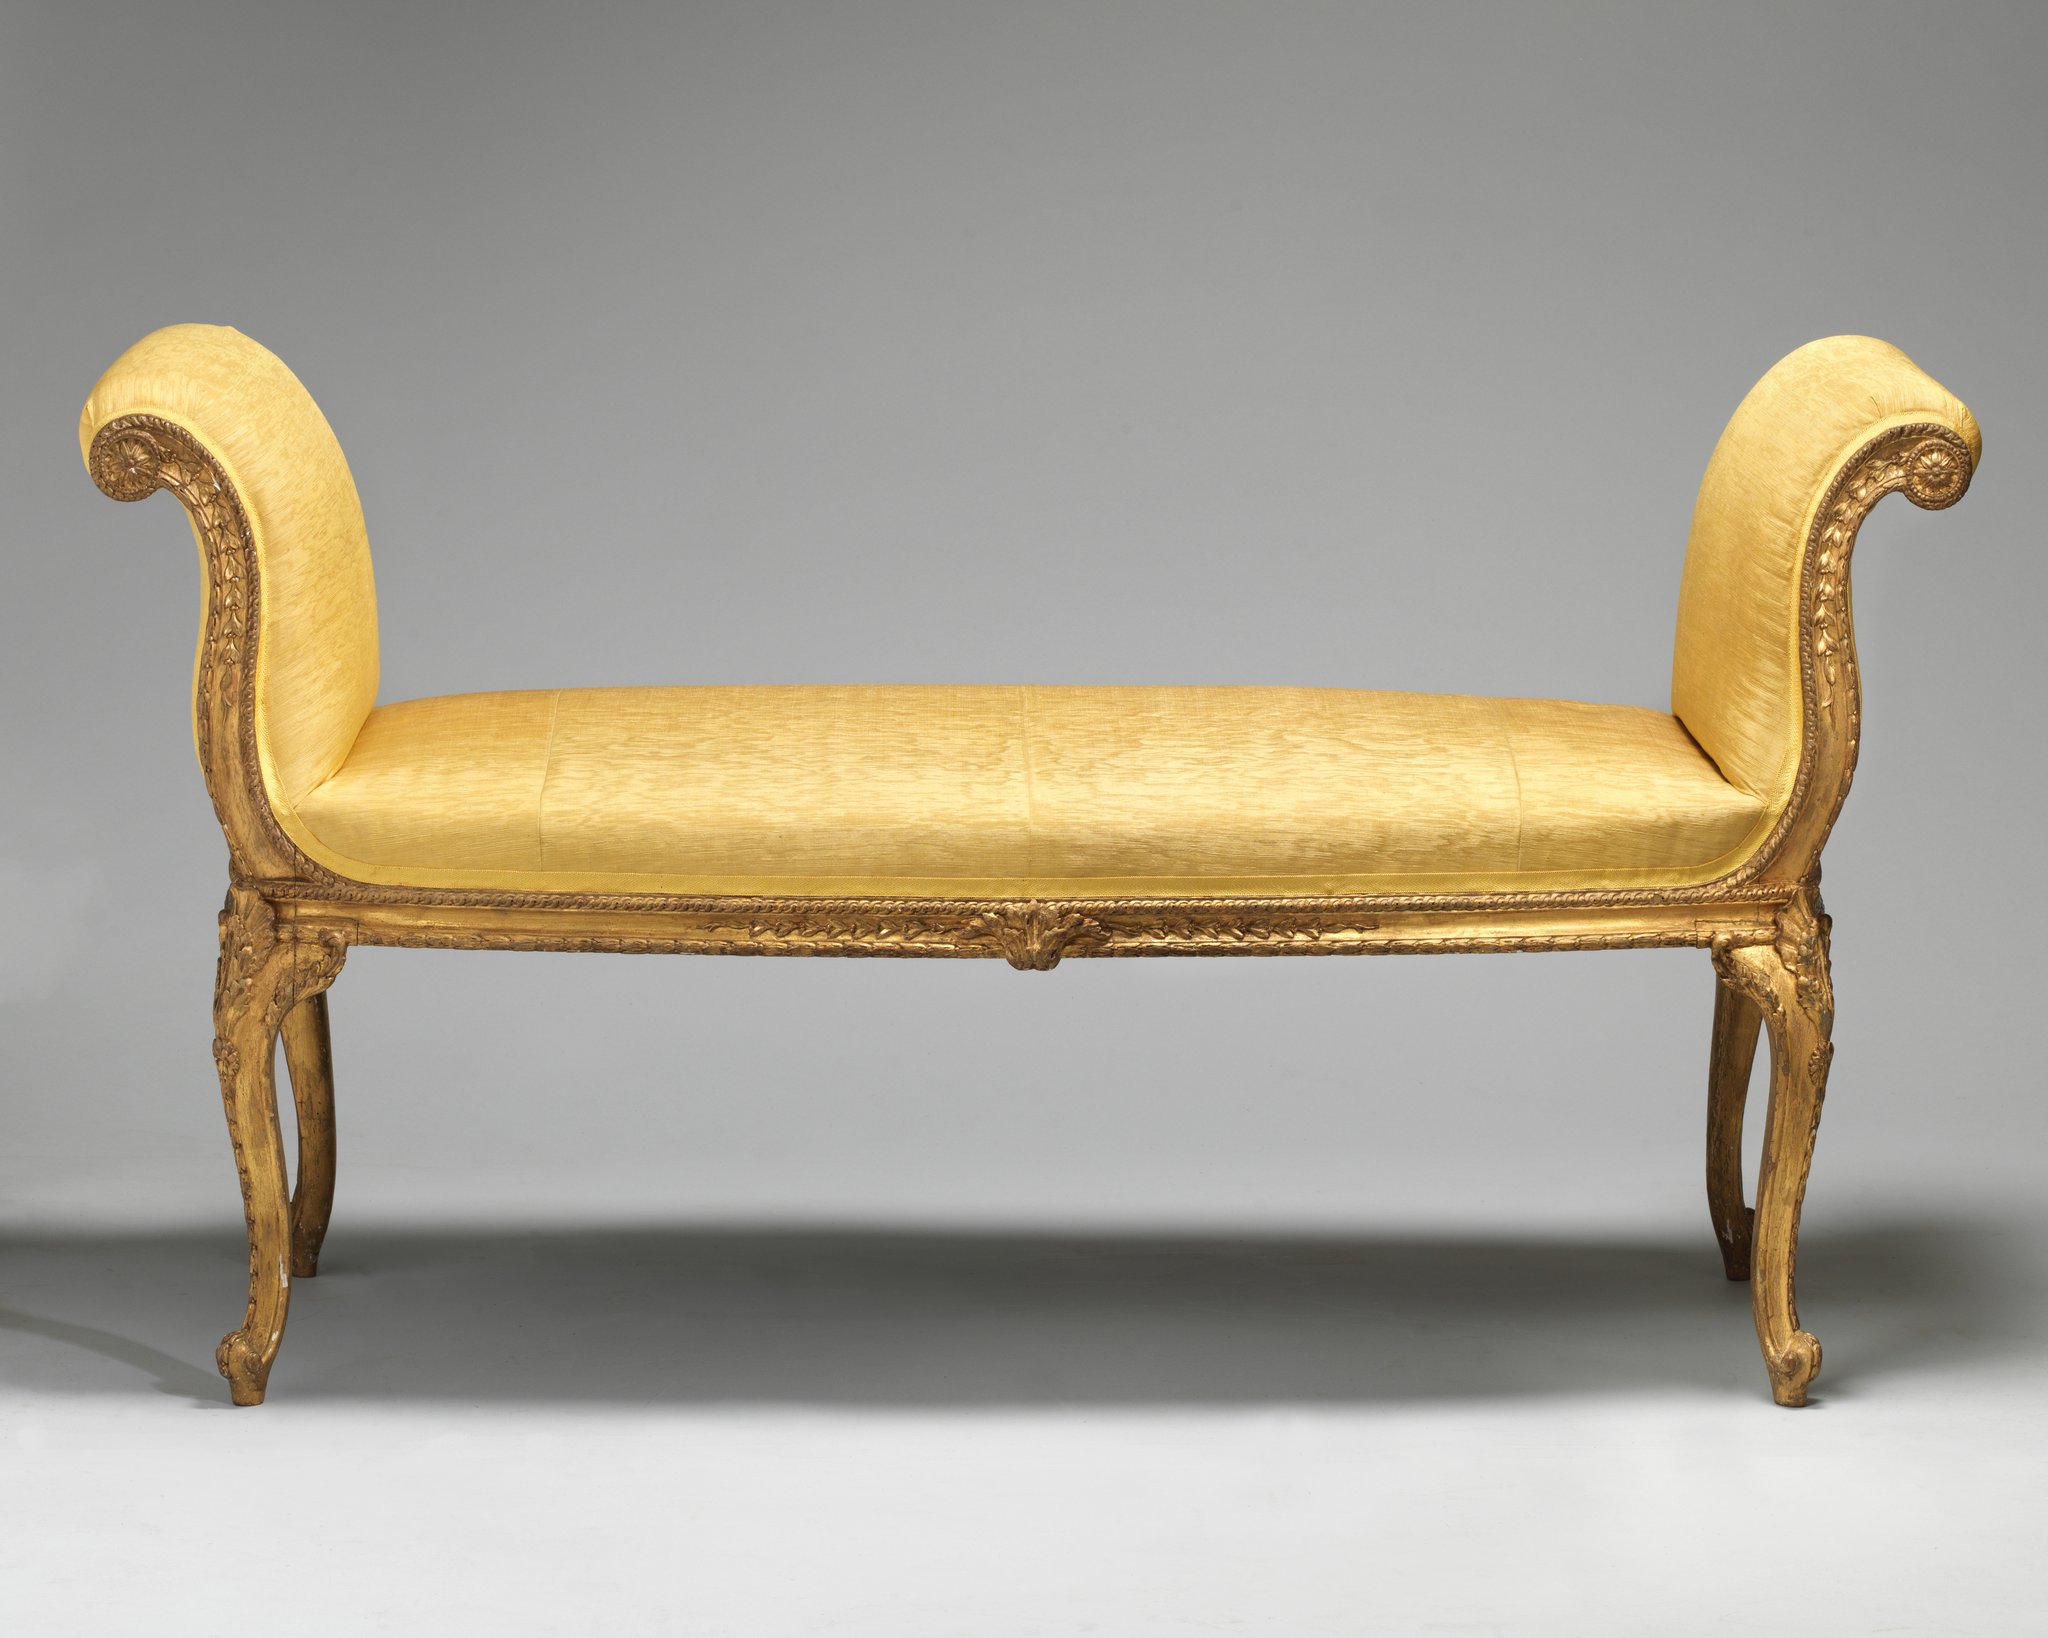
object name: window seat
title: Window seat (one of a pair) (part of a set)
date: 1770-1780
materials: wood